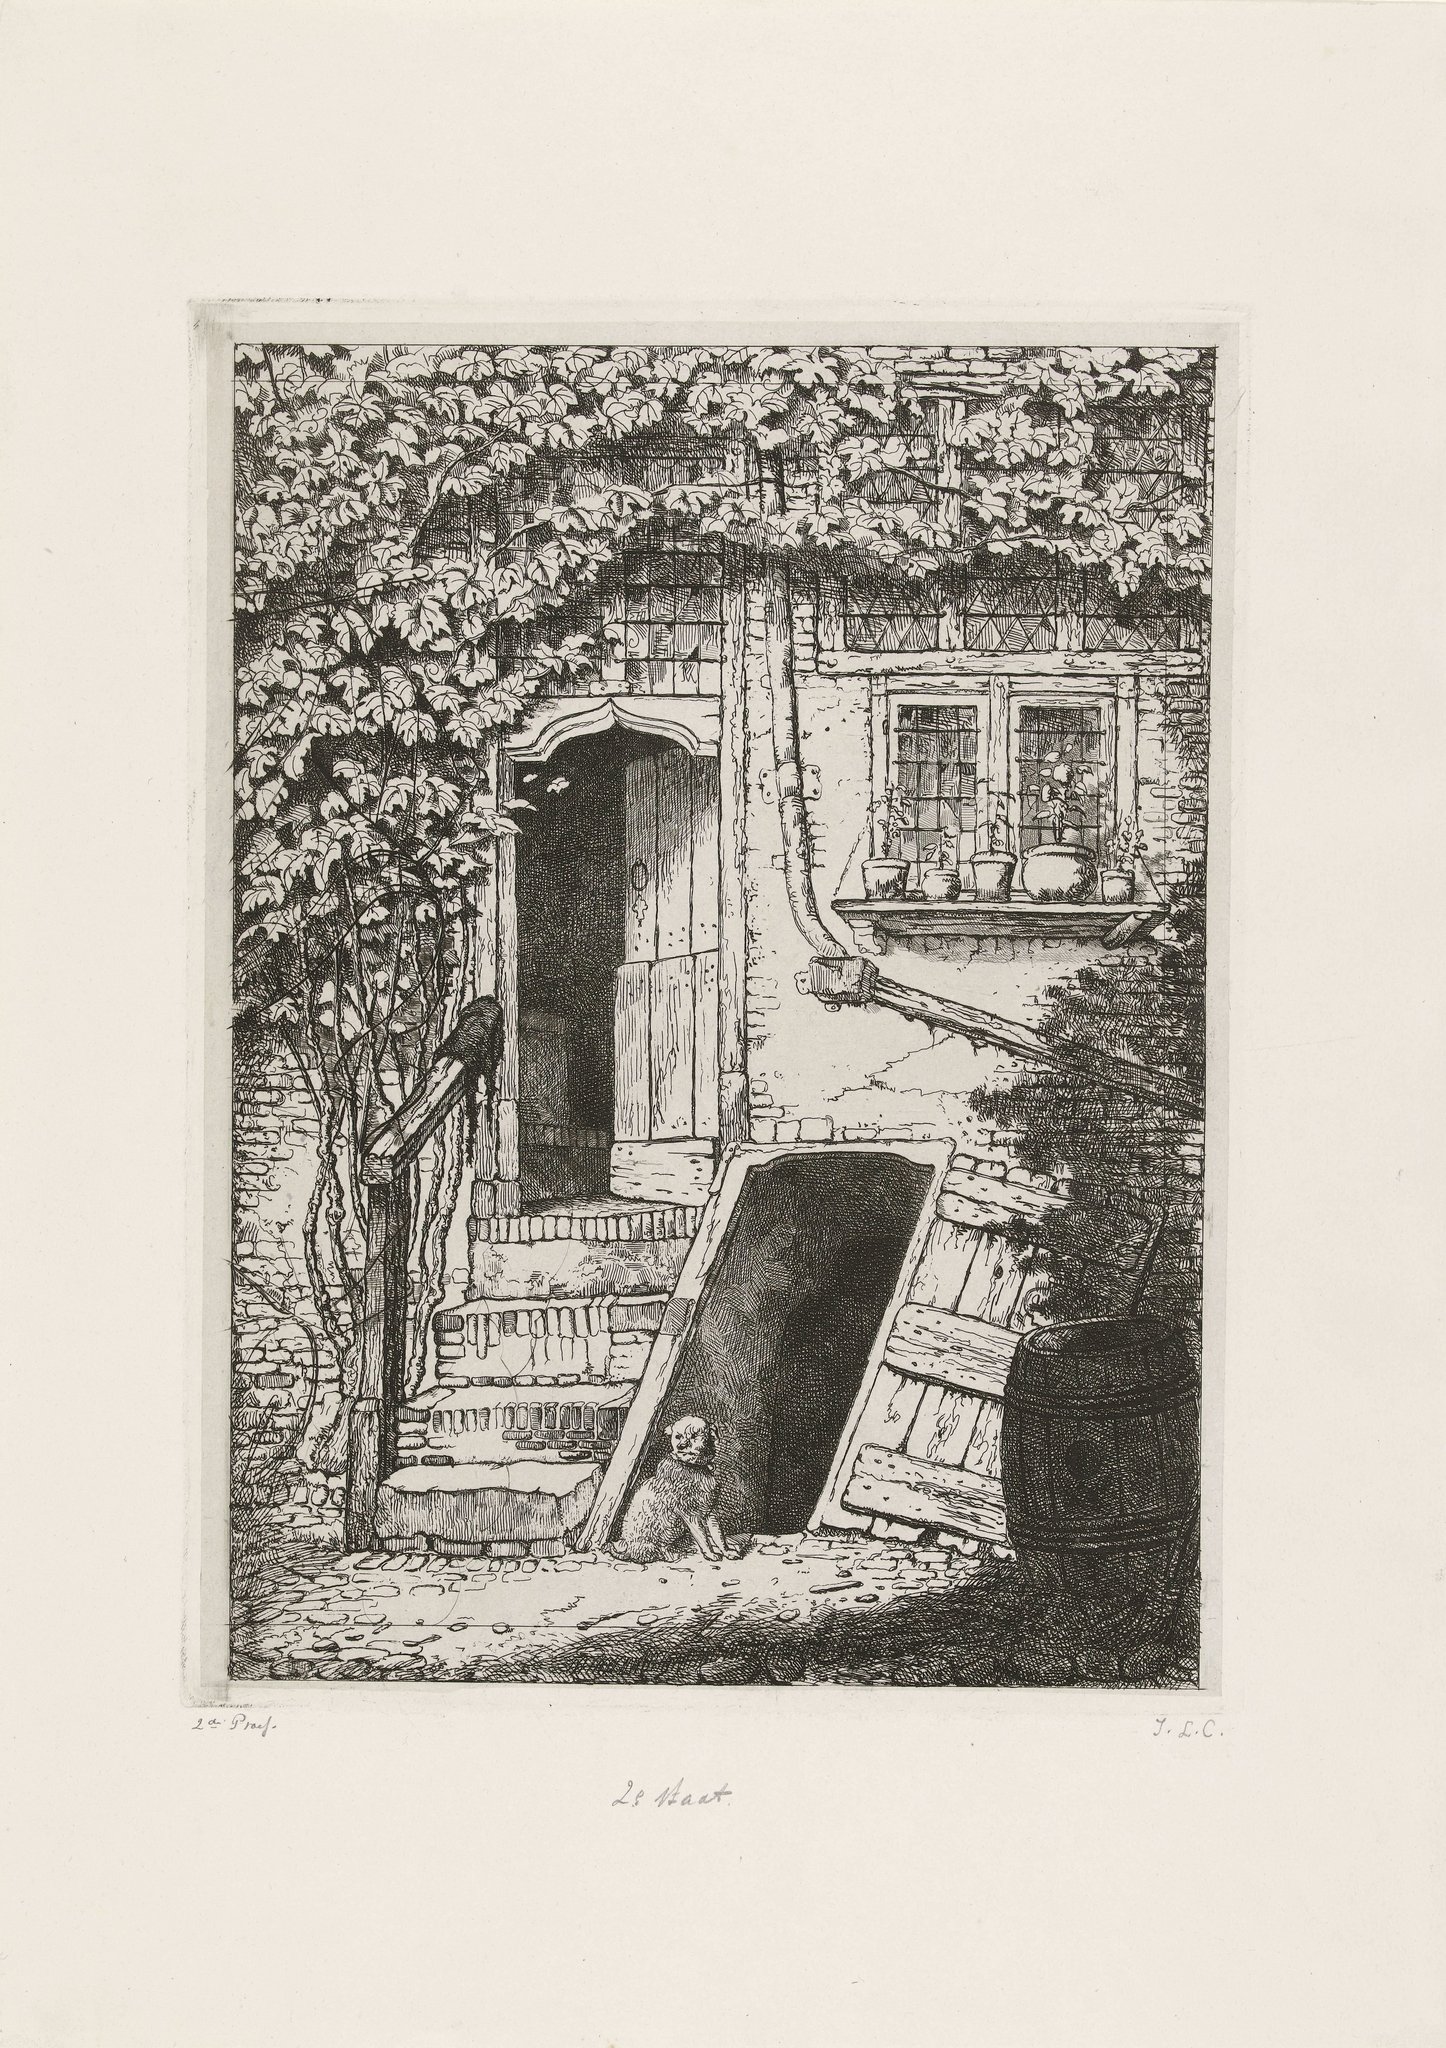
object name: print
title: Façade van een huis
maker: jacobus ludovicus cornet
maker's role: draughtsman, print maker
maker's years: 1815-1882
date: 1825-1882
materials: paper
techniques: etching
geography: leiden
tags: front façade, dog, plants and herbs: ivy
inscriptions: collector's mark: Lugt 2166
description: Façade van een huis. Een trap leidt naar het portaal en een half open staande deur. De kelderdeur staat ook open. Een schoothondje zit voor de kelderdeuropening.